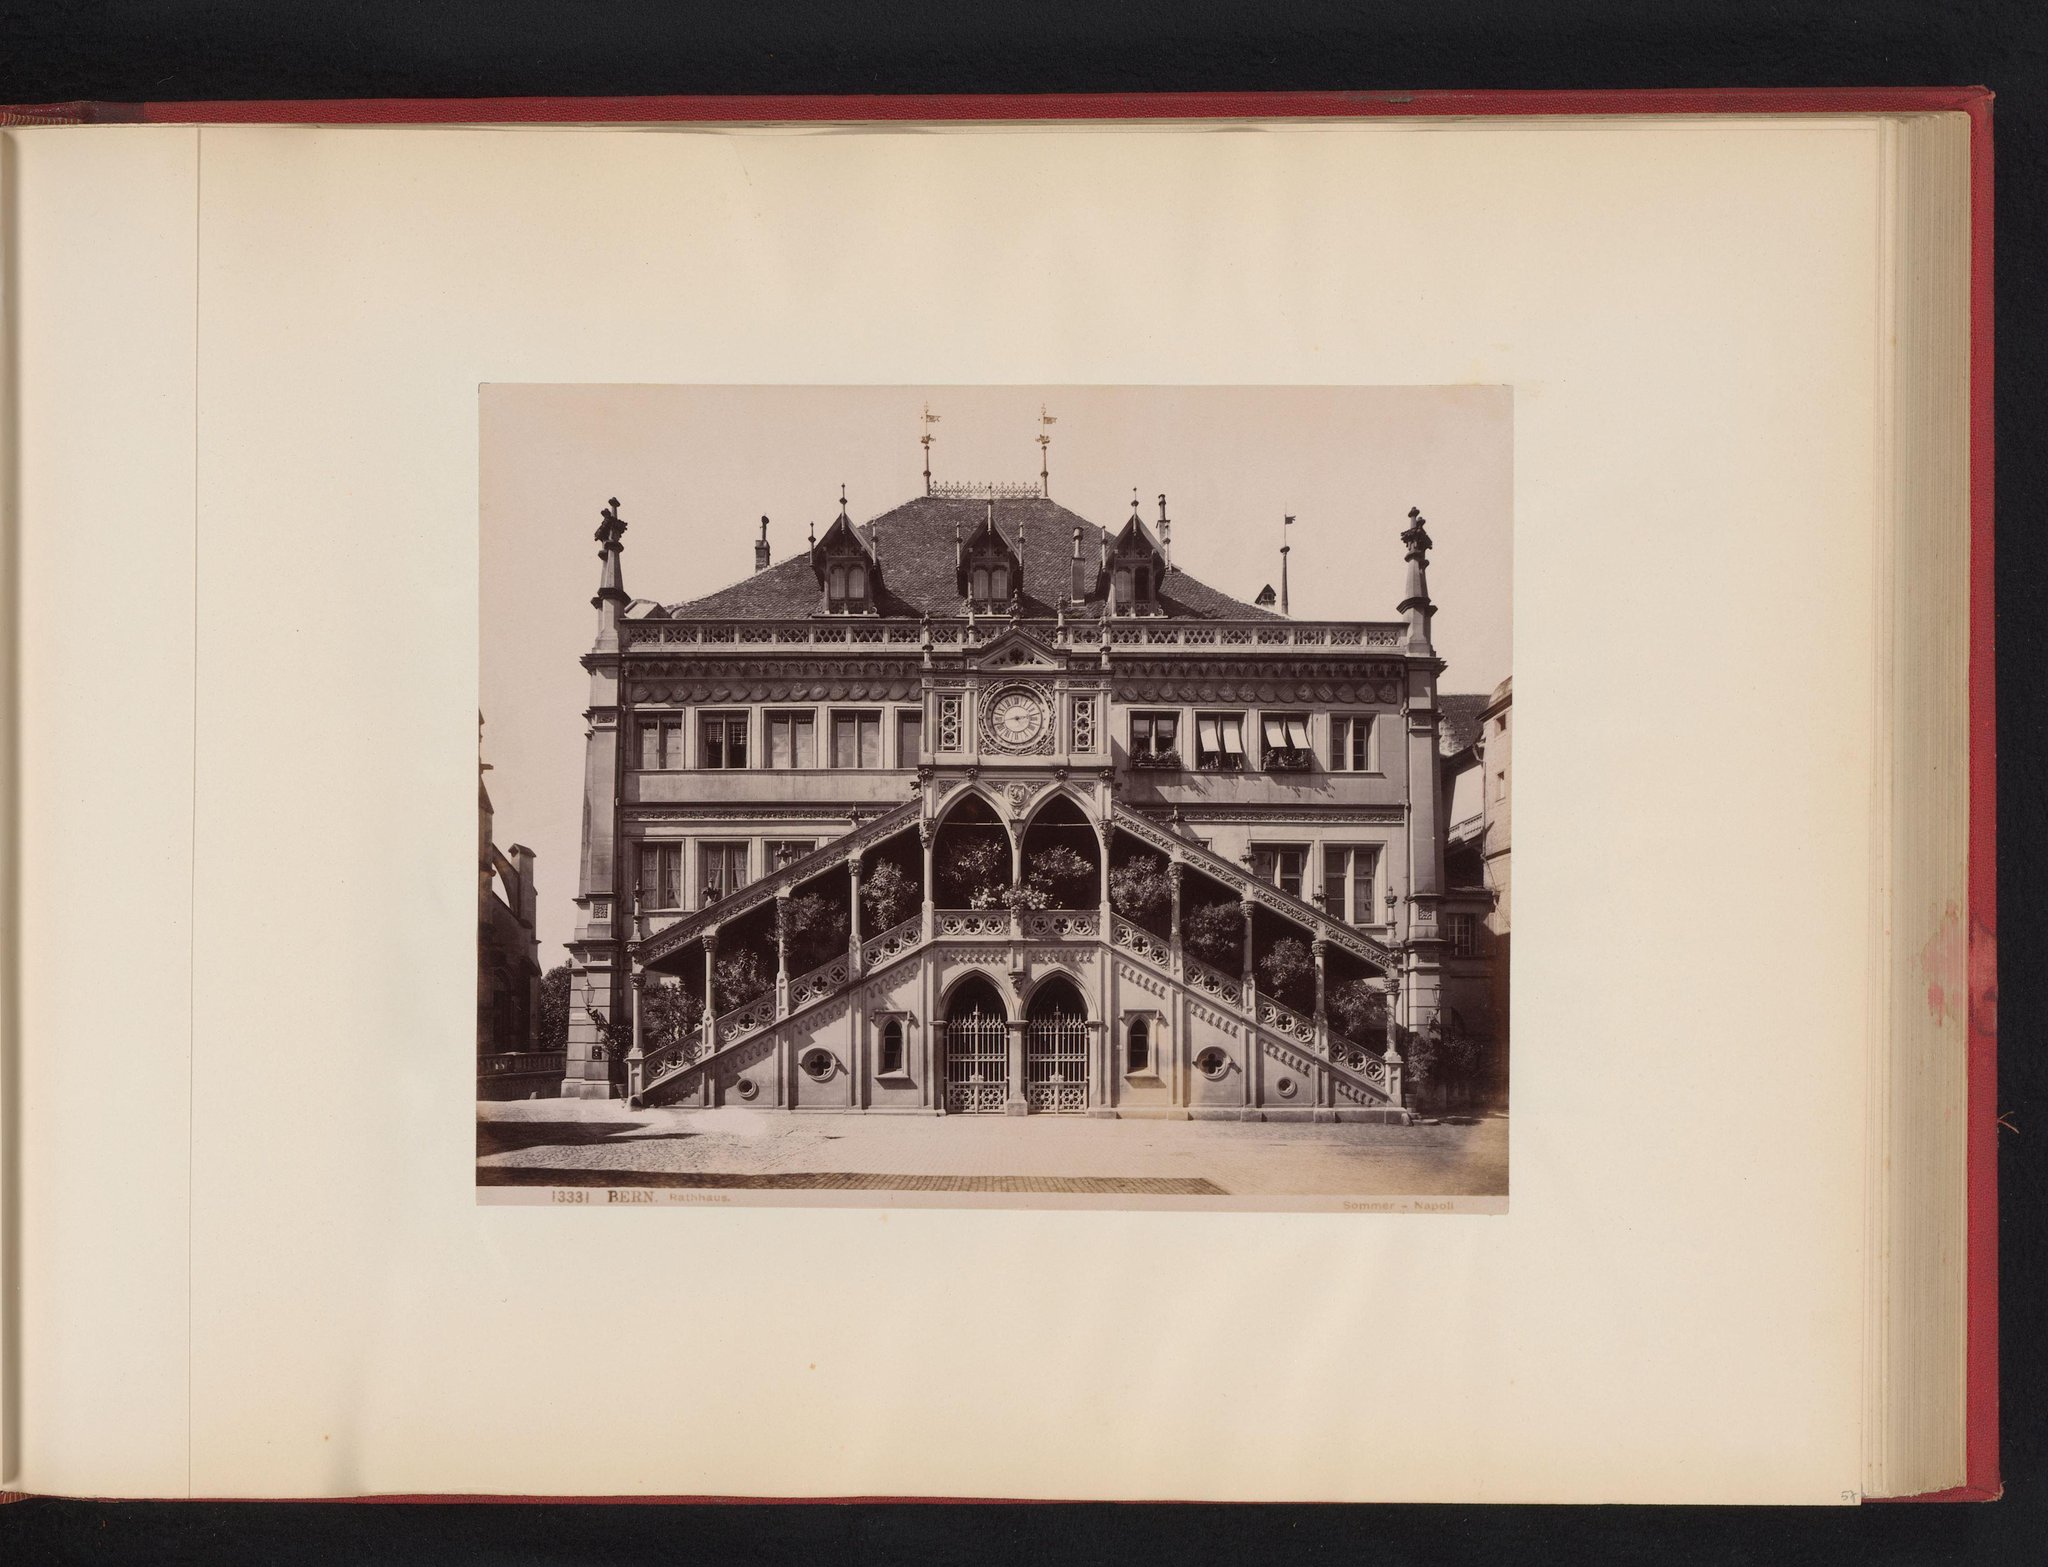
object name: photograph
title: Gezicht op het stadhuis te Bern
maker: giorgio sommer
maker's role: fotograaf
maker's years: 1834-1914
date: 1880-1900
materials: photographic support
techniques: albumen print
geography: bern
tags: townhall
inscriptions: inscription: ‘13331 Bern. Rathaus. Sommer - Napoli’